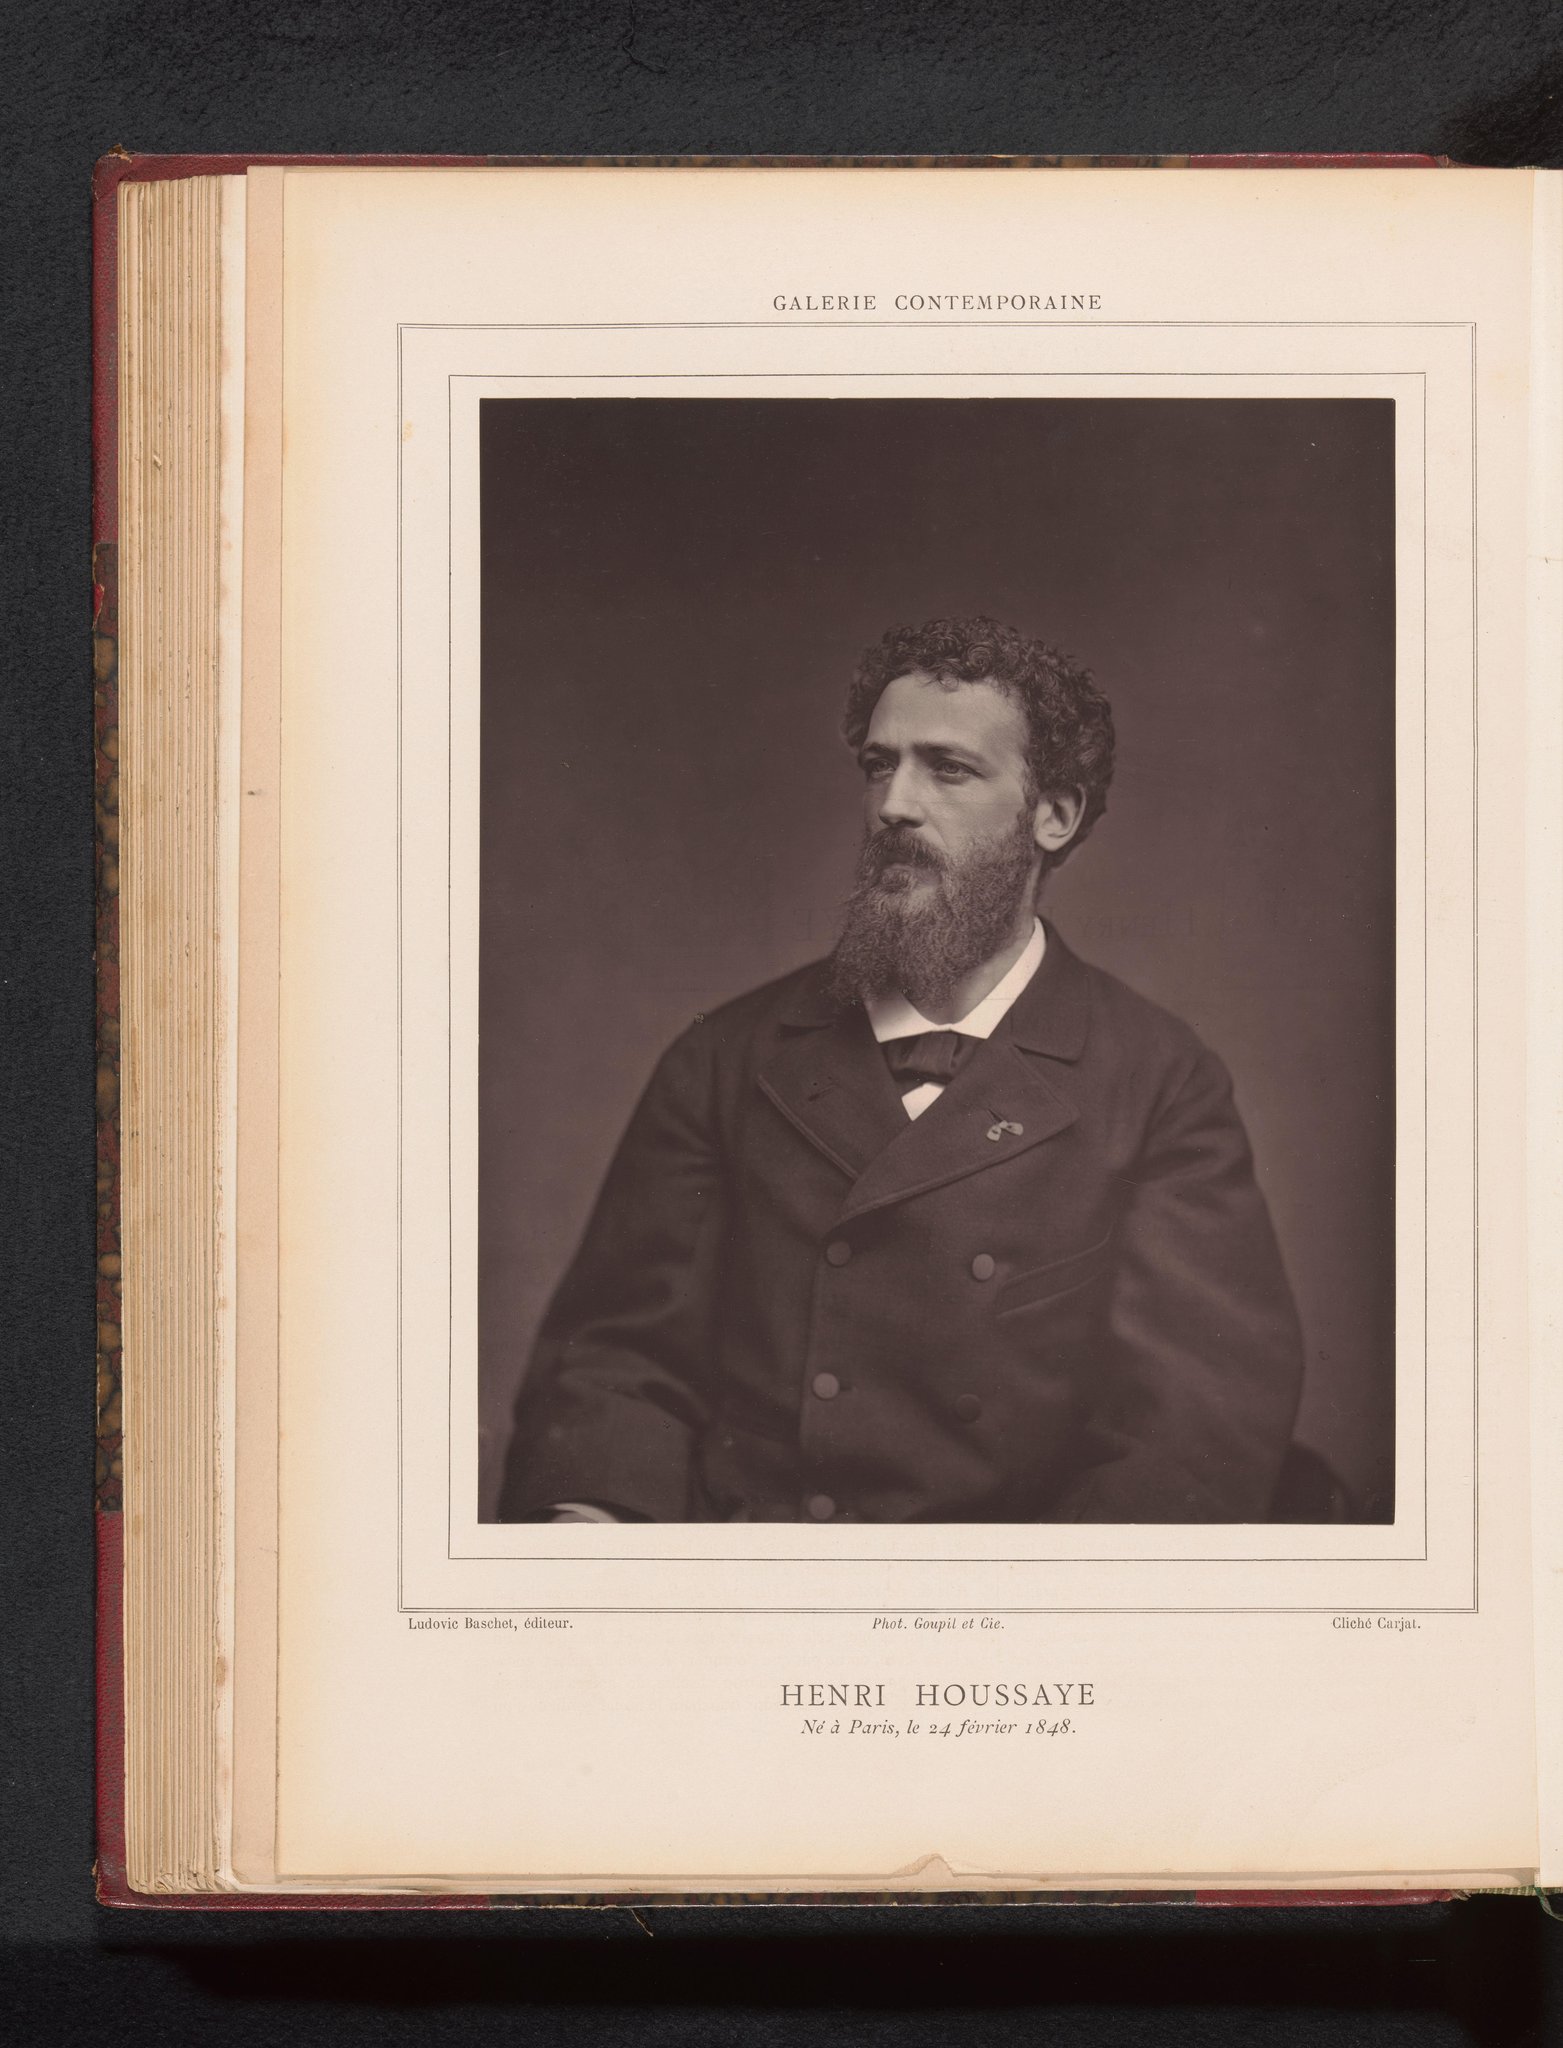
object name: page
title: Portret van Henri Houssaye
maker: étienne carjat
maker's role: draughtsman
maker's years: 1828-1906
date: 1867-1880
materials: paper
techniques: woodburytype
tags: paris, adult man, historical persons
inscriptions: inscription: ‘Galerie Contemporaine/ Ludovic Baschet, éditeur./ Né a Paris, le 24 fevrier 1848.’